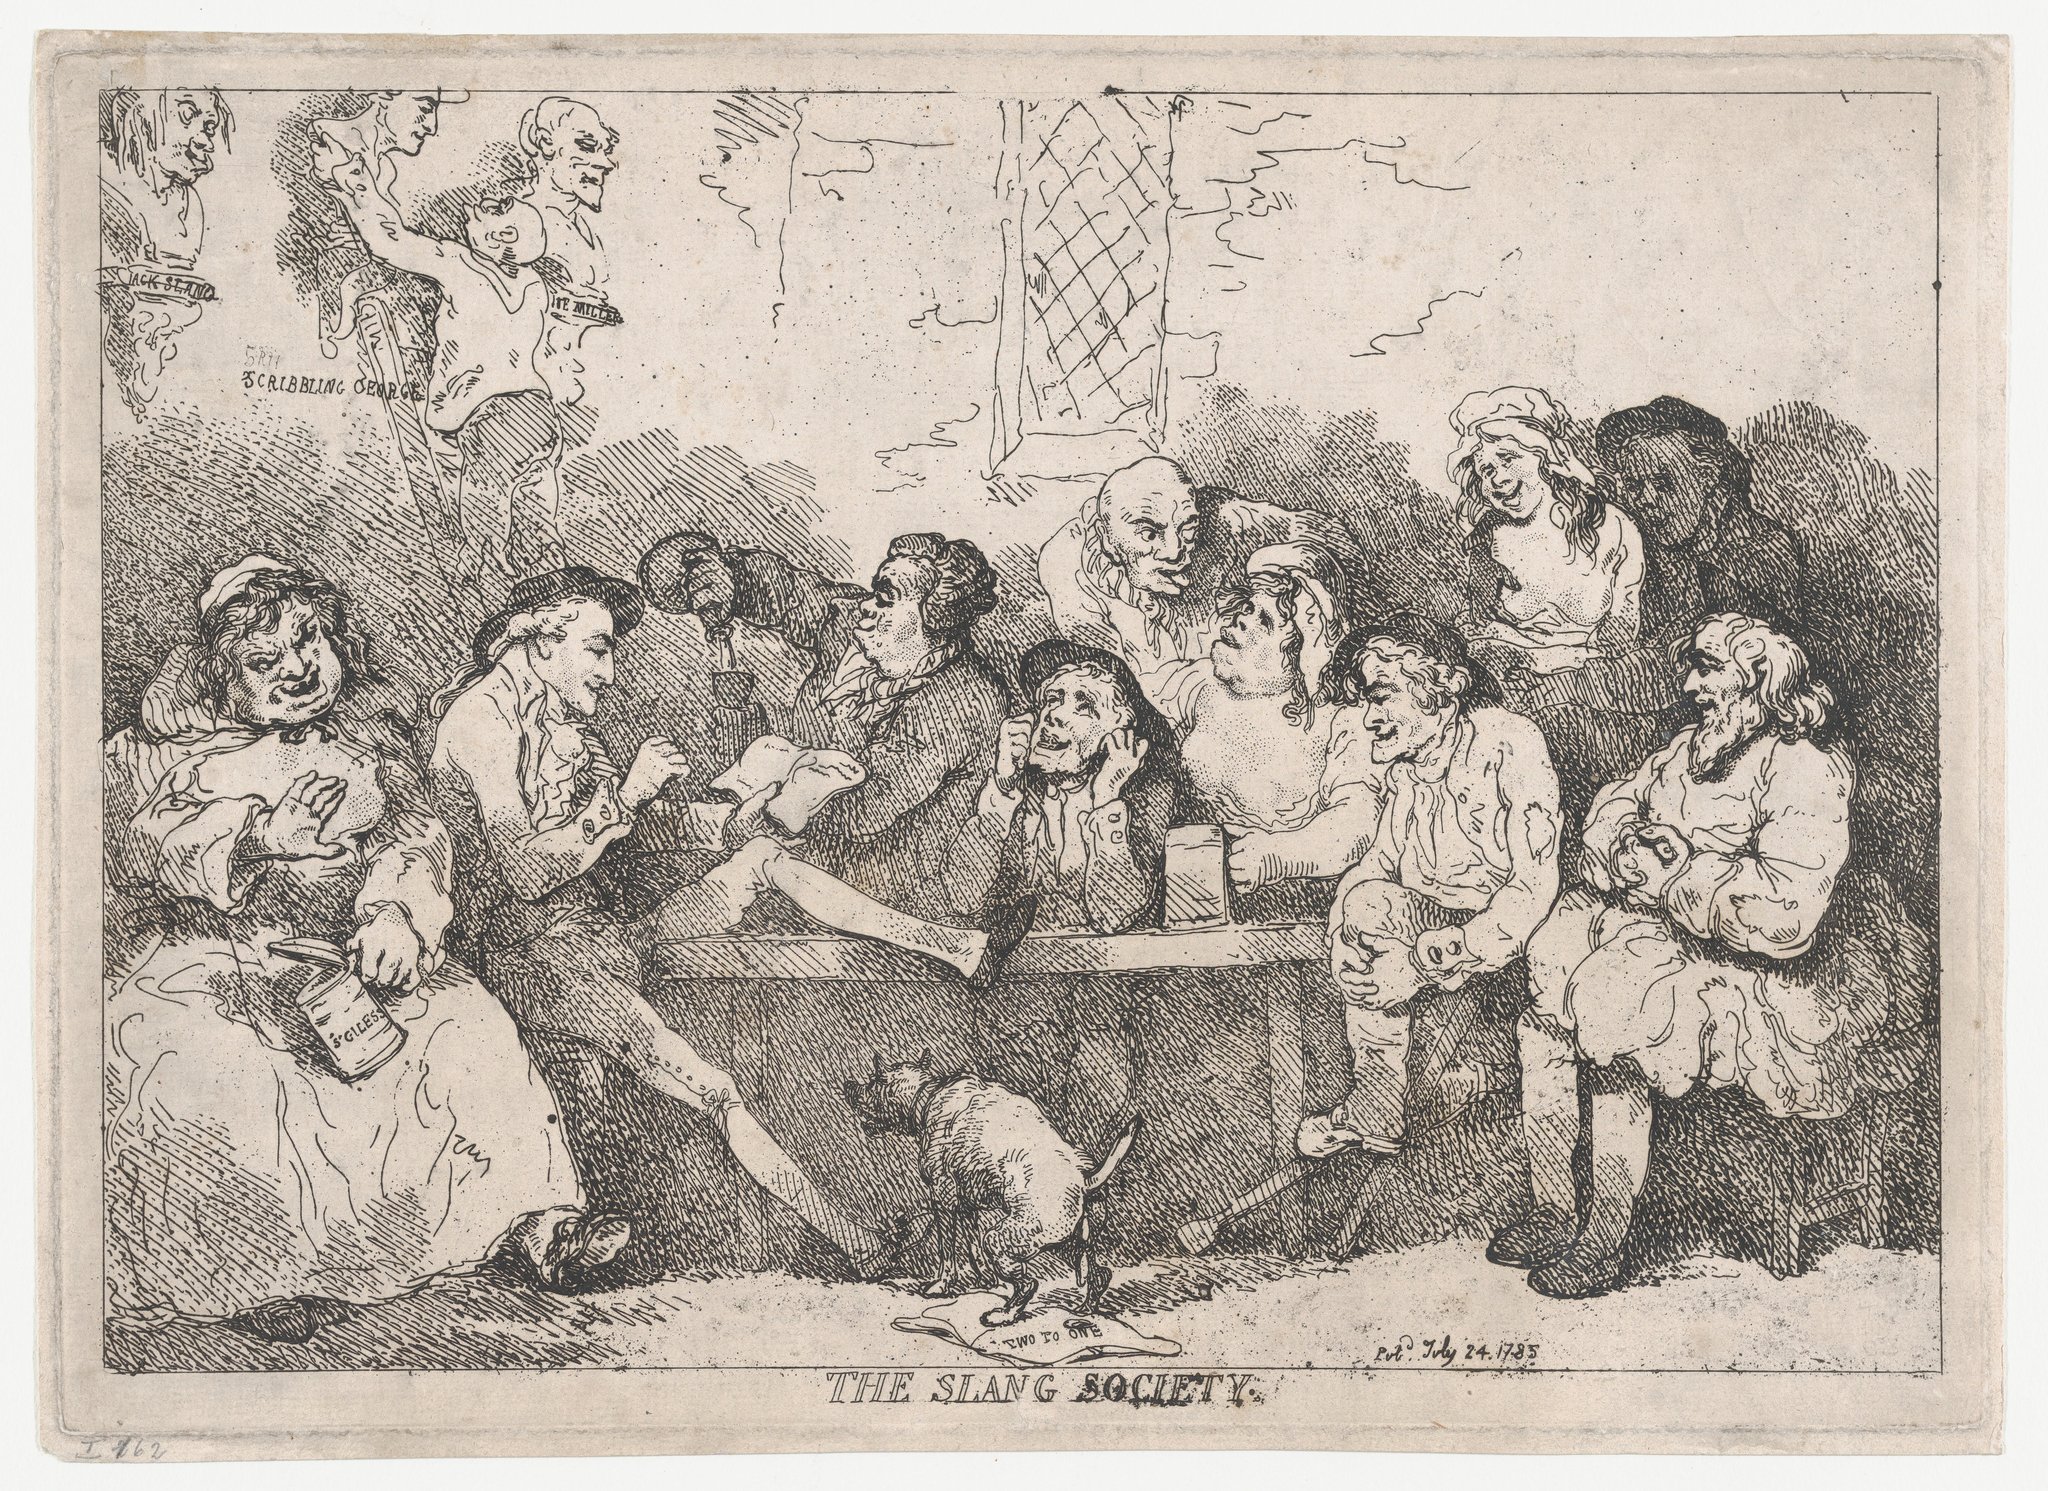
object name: print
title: The Slang Society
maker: thomas rowlandson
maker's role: artist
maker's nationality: british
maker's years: 1757-1827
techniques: etching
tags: men,women